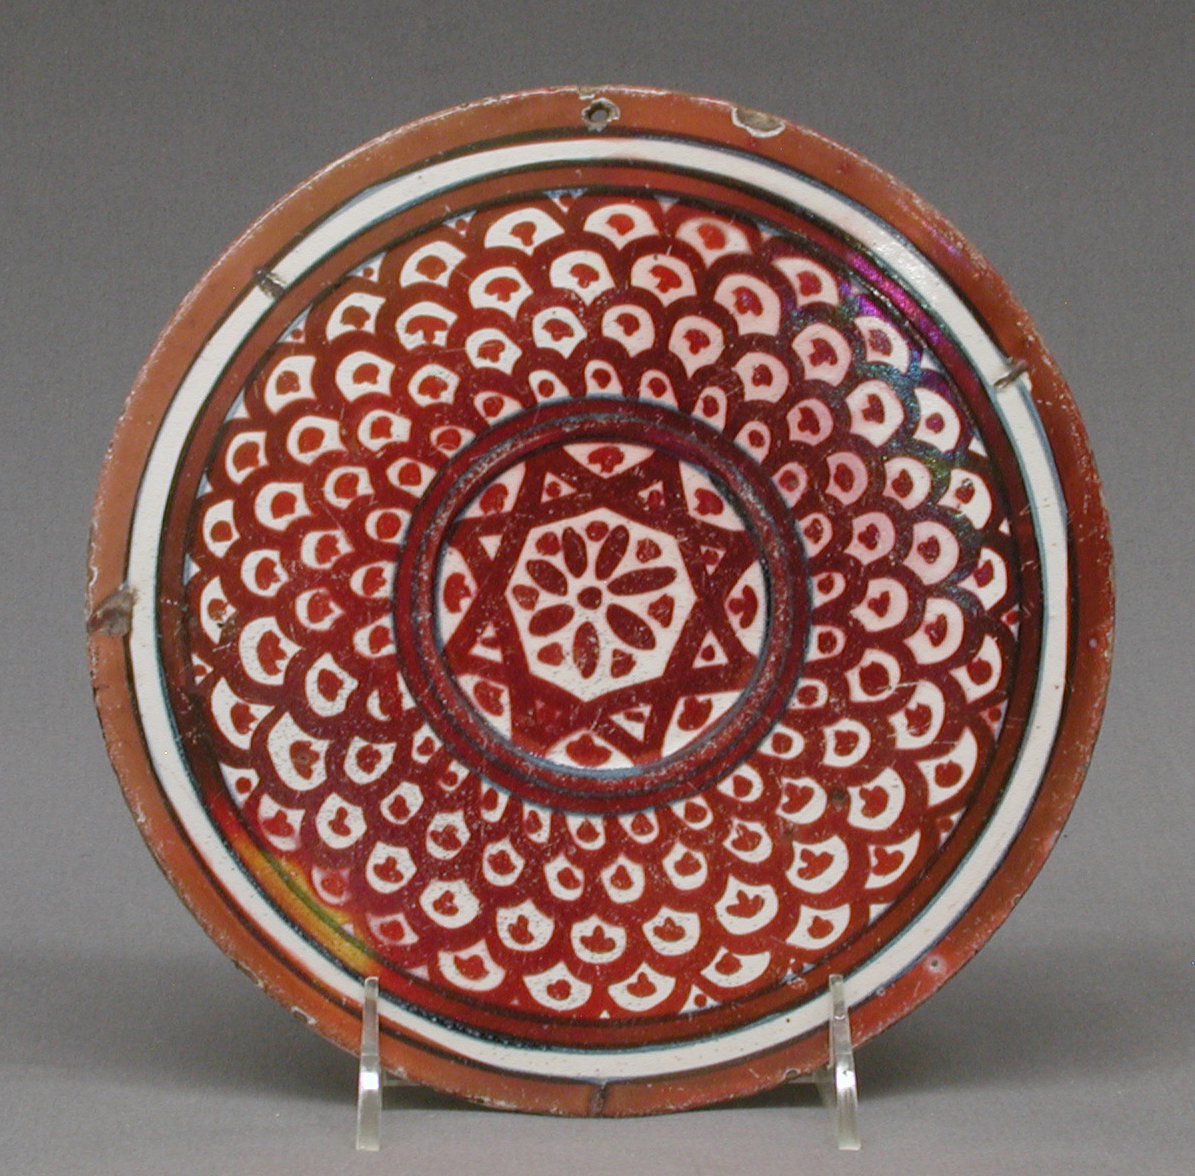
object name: plaque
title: Plaque (Mugiuolo)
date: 1520-1535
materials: earthenware